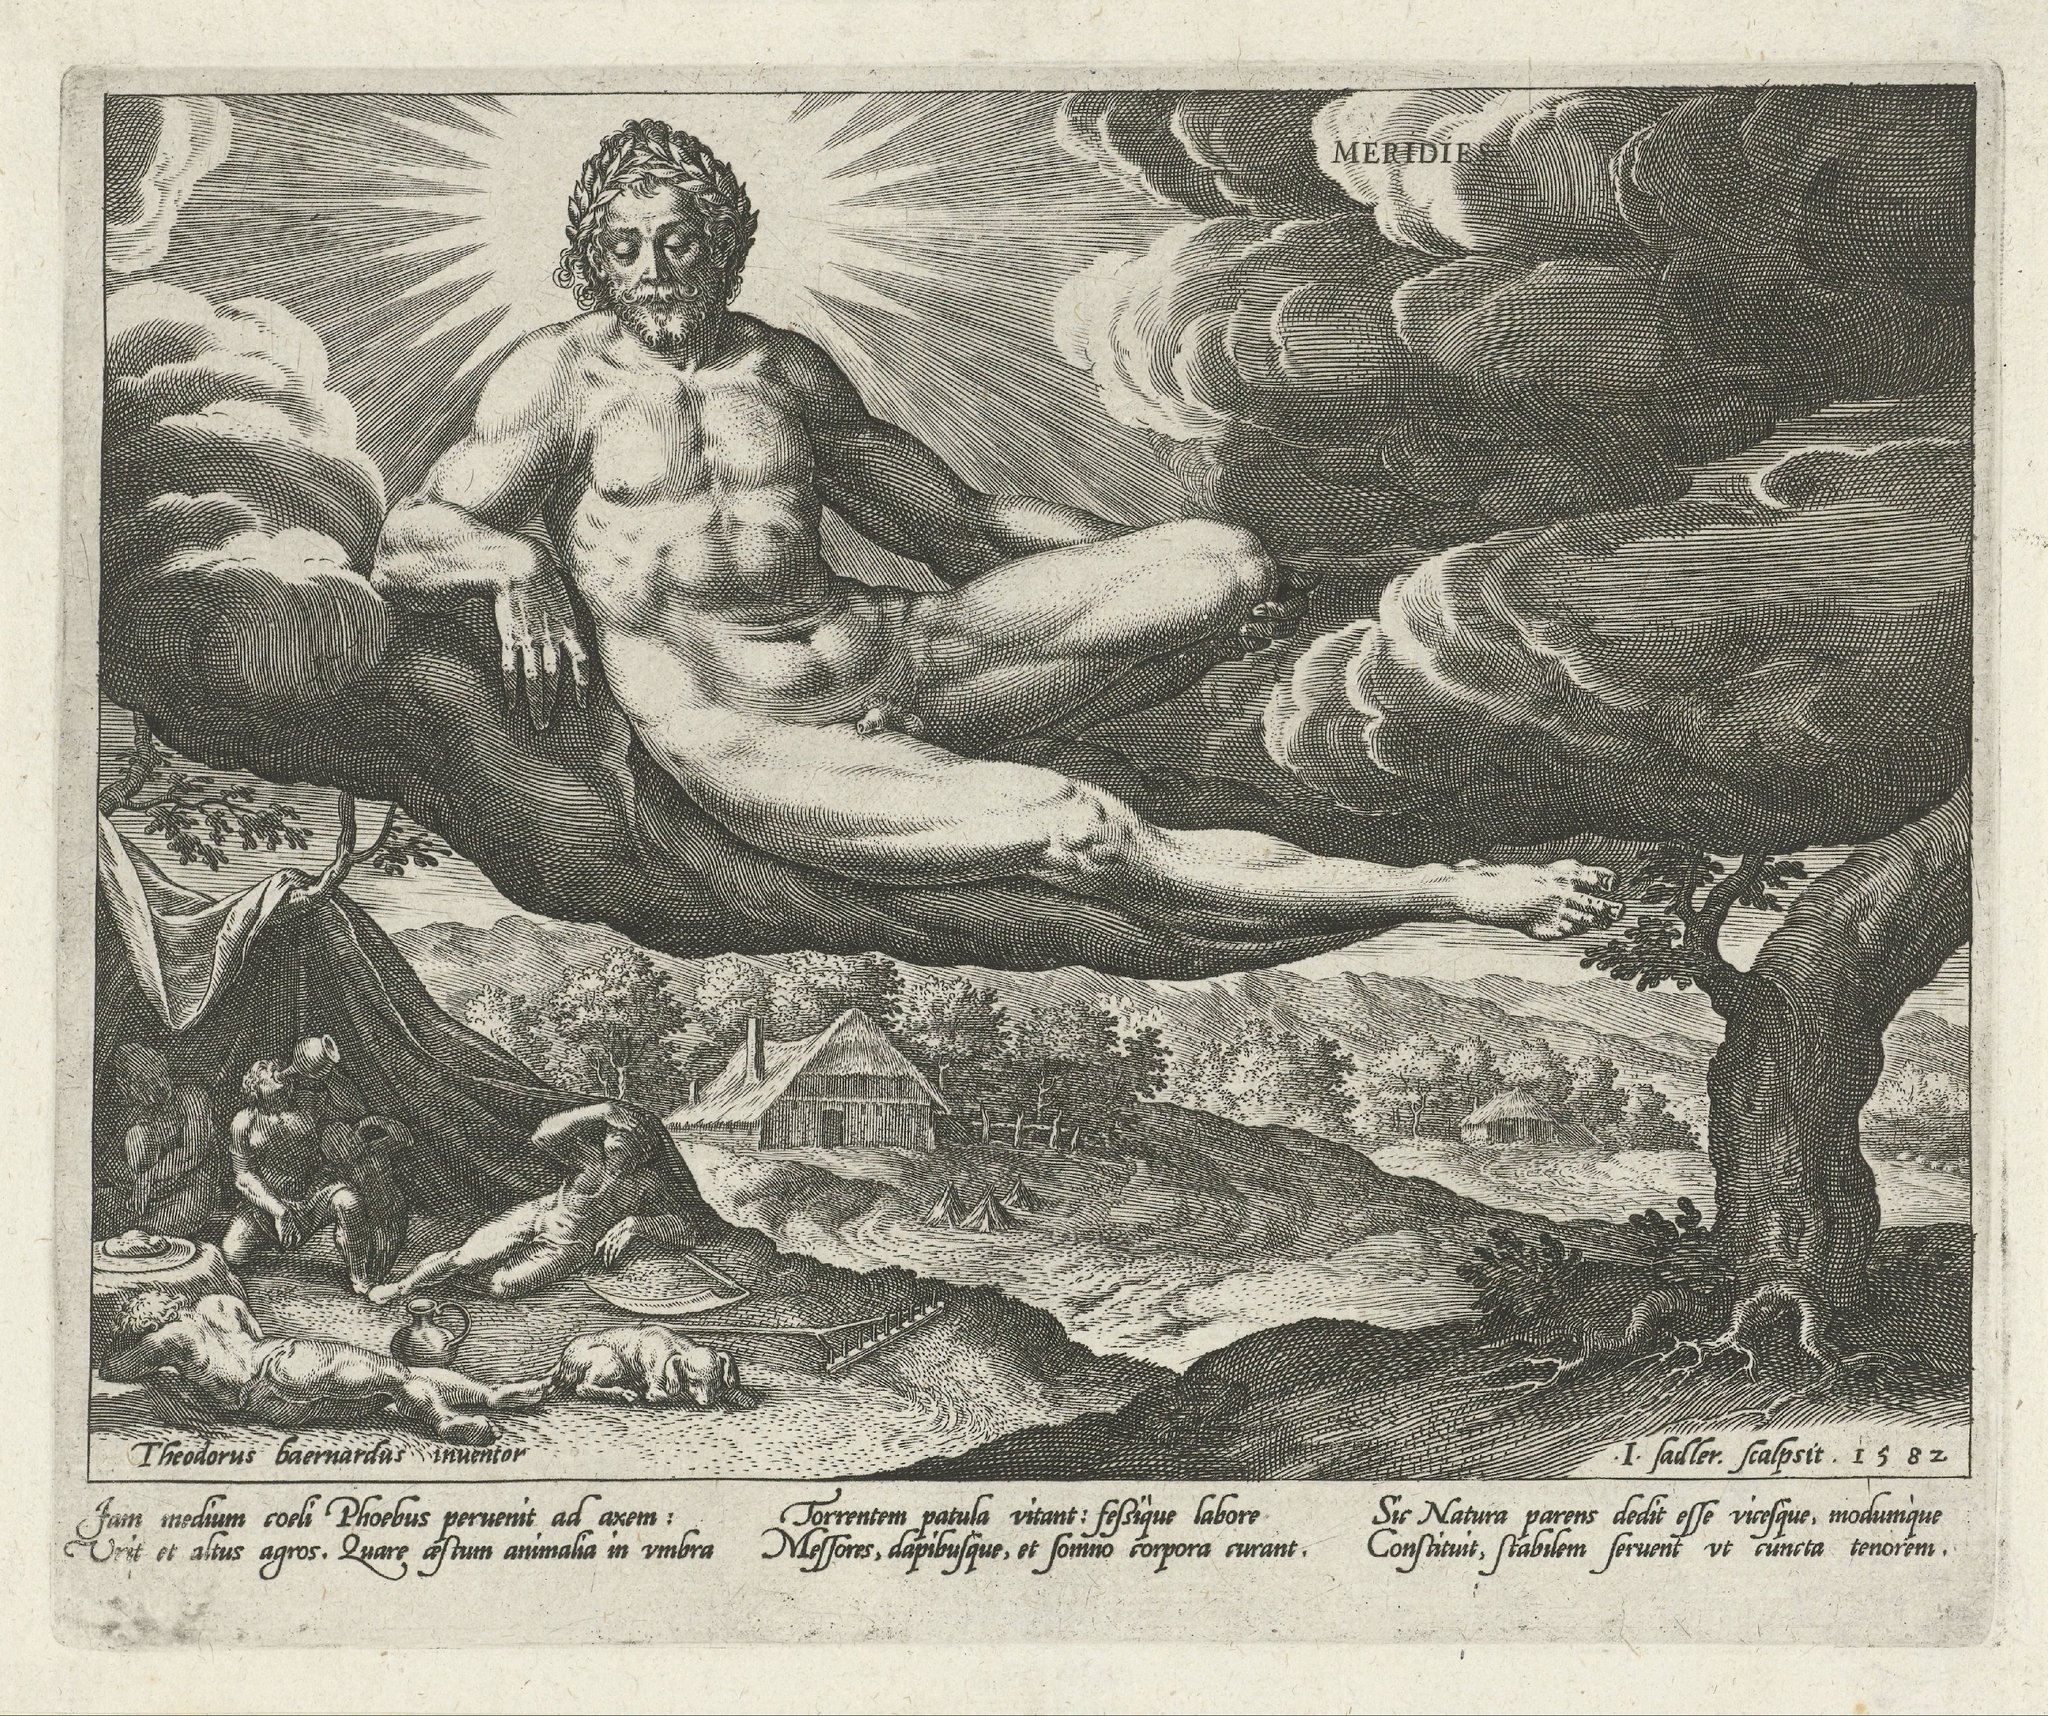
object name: print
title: De vier delen van de dag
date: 1582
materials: paper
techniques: engraving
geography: cologne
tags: siesta, (story of) apollo (phoebus), afternoon ~ landscape (sometimes titled 'meridies'), afternoon, personification of the afternoon, 'meridies', resting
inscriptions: collector's mark: Lugt 240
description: In de wolken de naakte Apollo als personificatie van de middag. Rond zijn hoofd de zon. Onder hem een middaglandschap met mensen die in de schaduw schuilen voor de zon. De mensen slapen of drinken. In de marge een Latijns onderschrift met uitleg over de middag. De prent maakt deel uit van een vierdelige serie over de delen van de dag en de menselijke activiteiten die tijdens dat deel van de dag worden gepleegd.